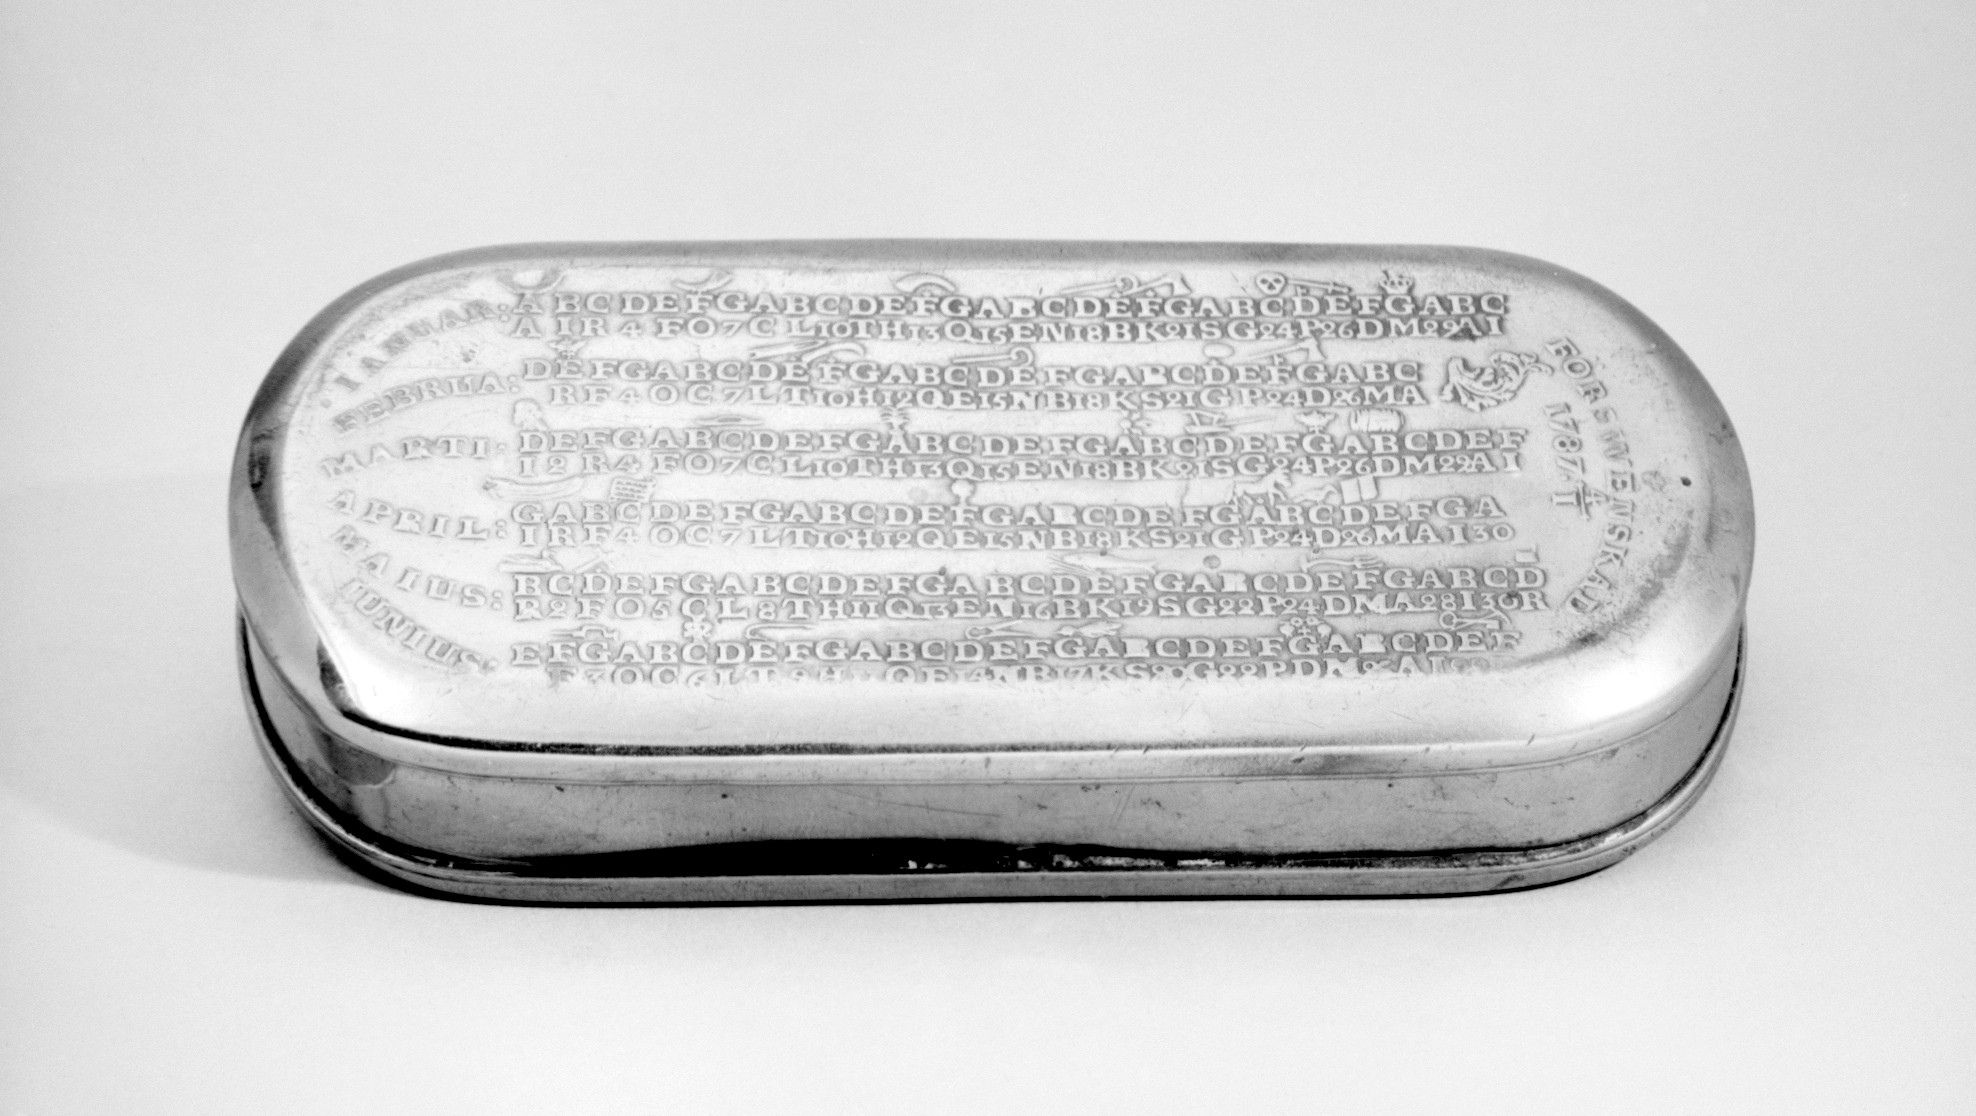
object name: tobacco box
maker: c. norman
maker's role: maker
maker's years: 1725-1825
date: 1787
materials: brass, copper